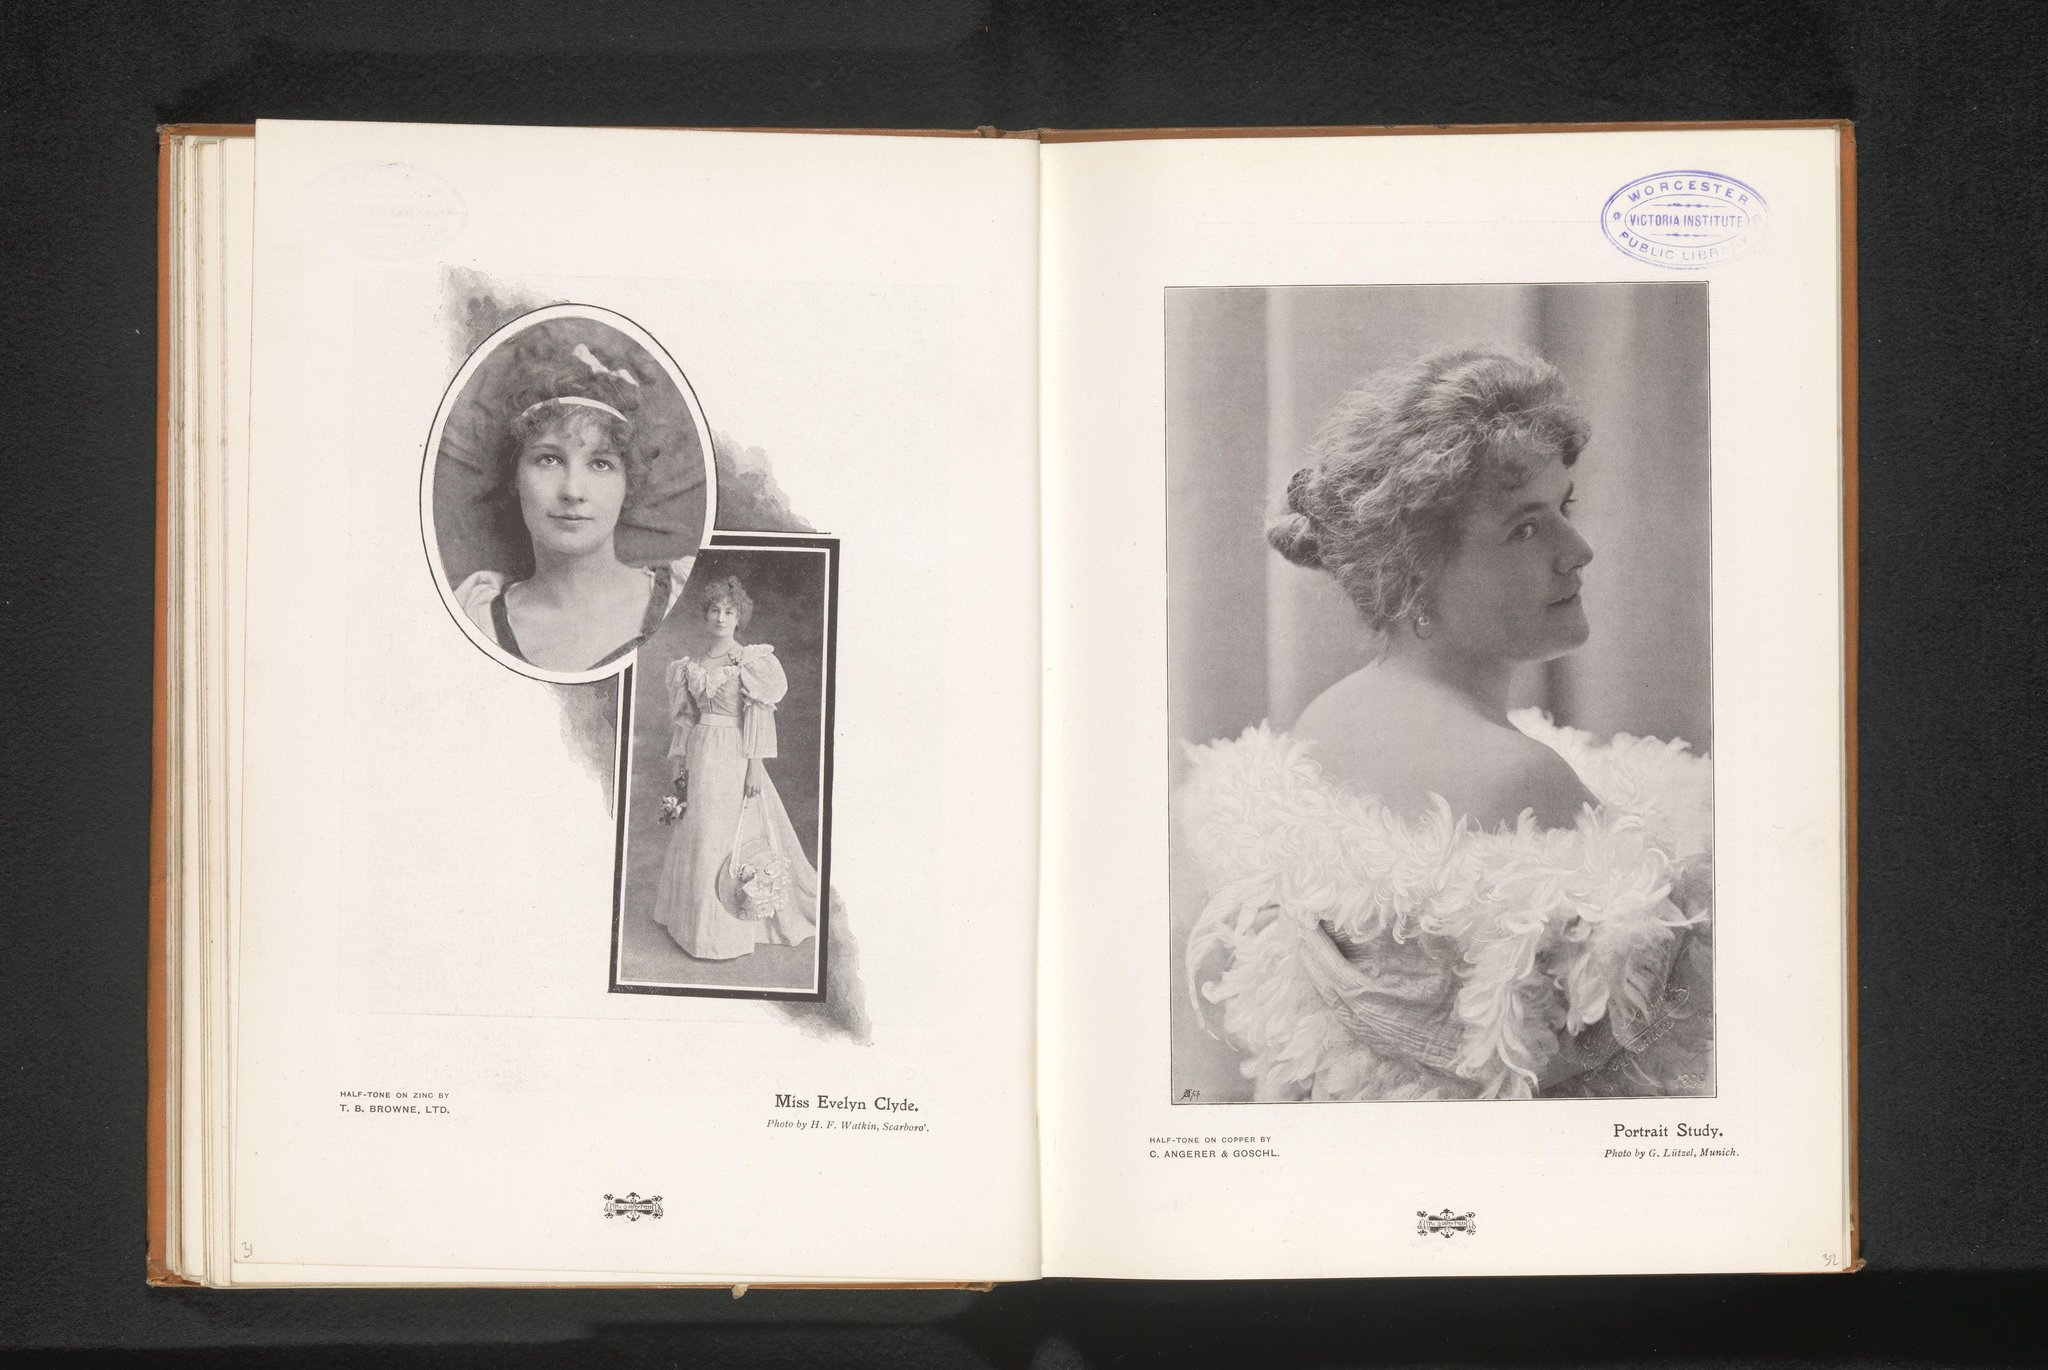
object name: page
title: Portret met uitvergroting van een onbekende jonge vrouw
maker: herbert e. watkin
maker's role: fotograaf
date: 1894-1899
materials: paper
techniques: autotype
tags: adolescent, young woman, maiden, historical persons - bb - woman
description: Prent op tweede ongenummerde pagina na pagina 48.